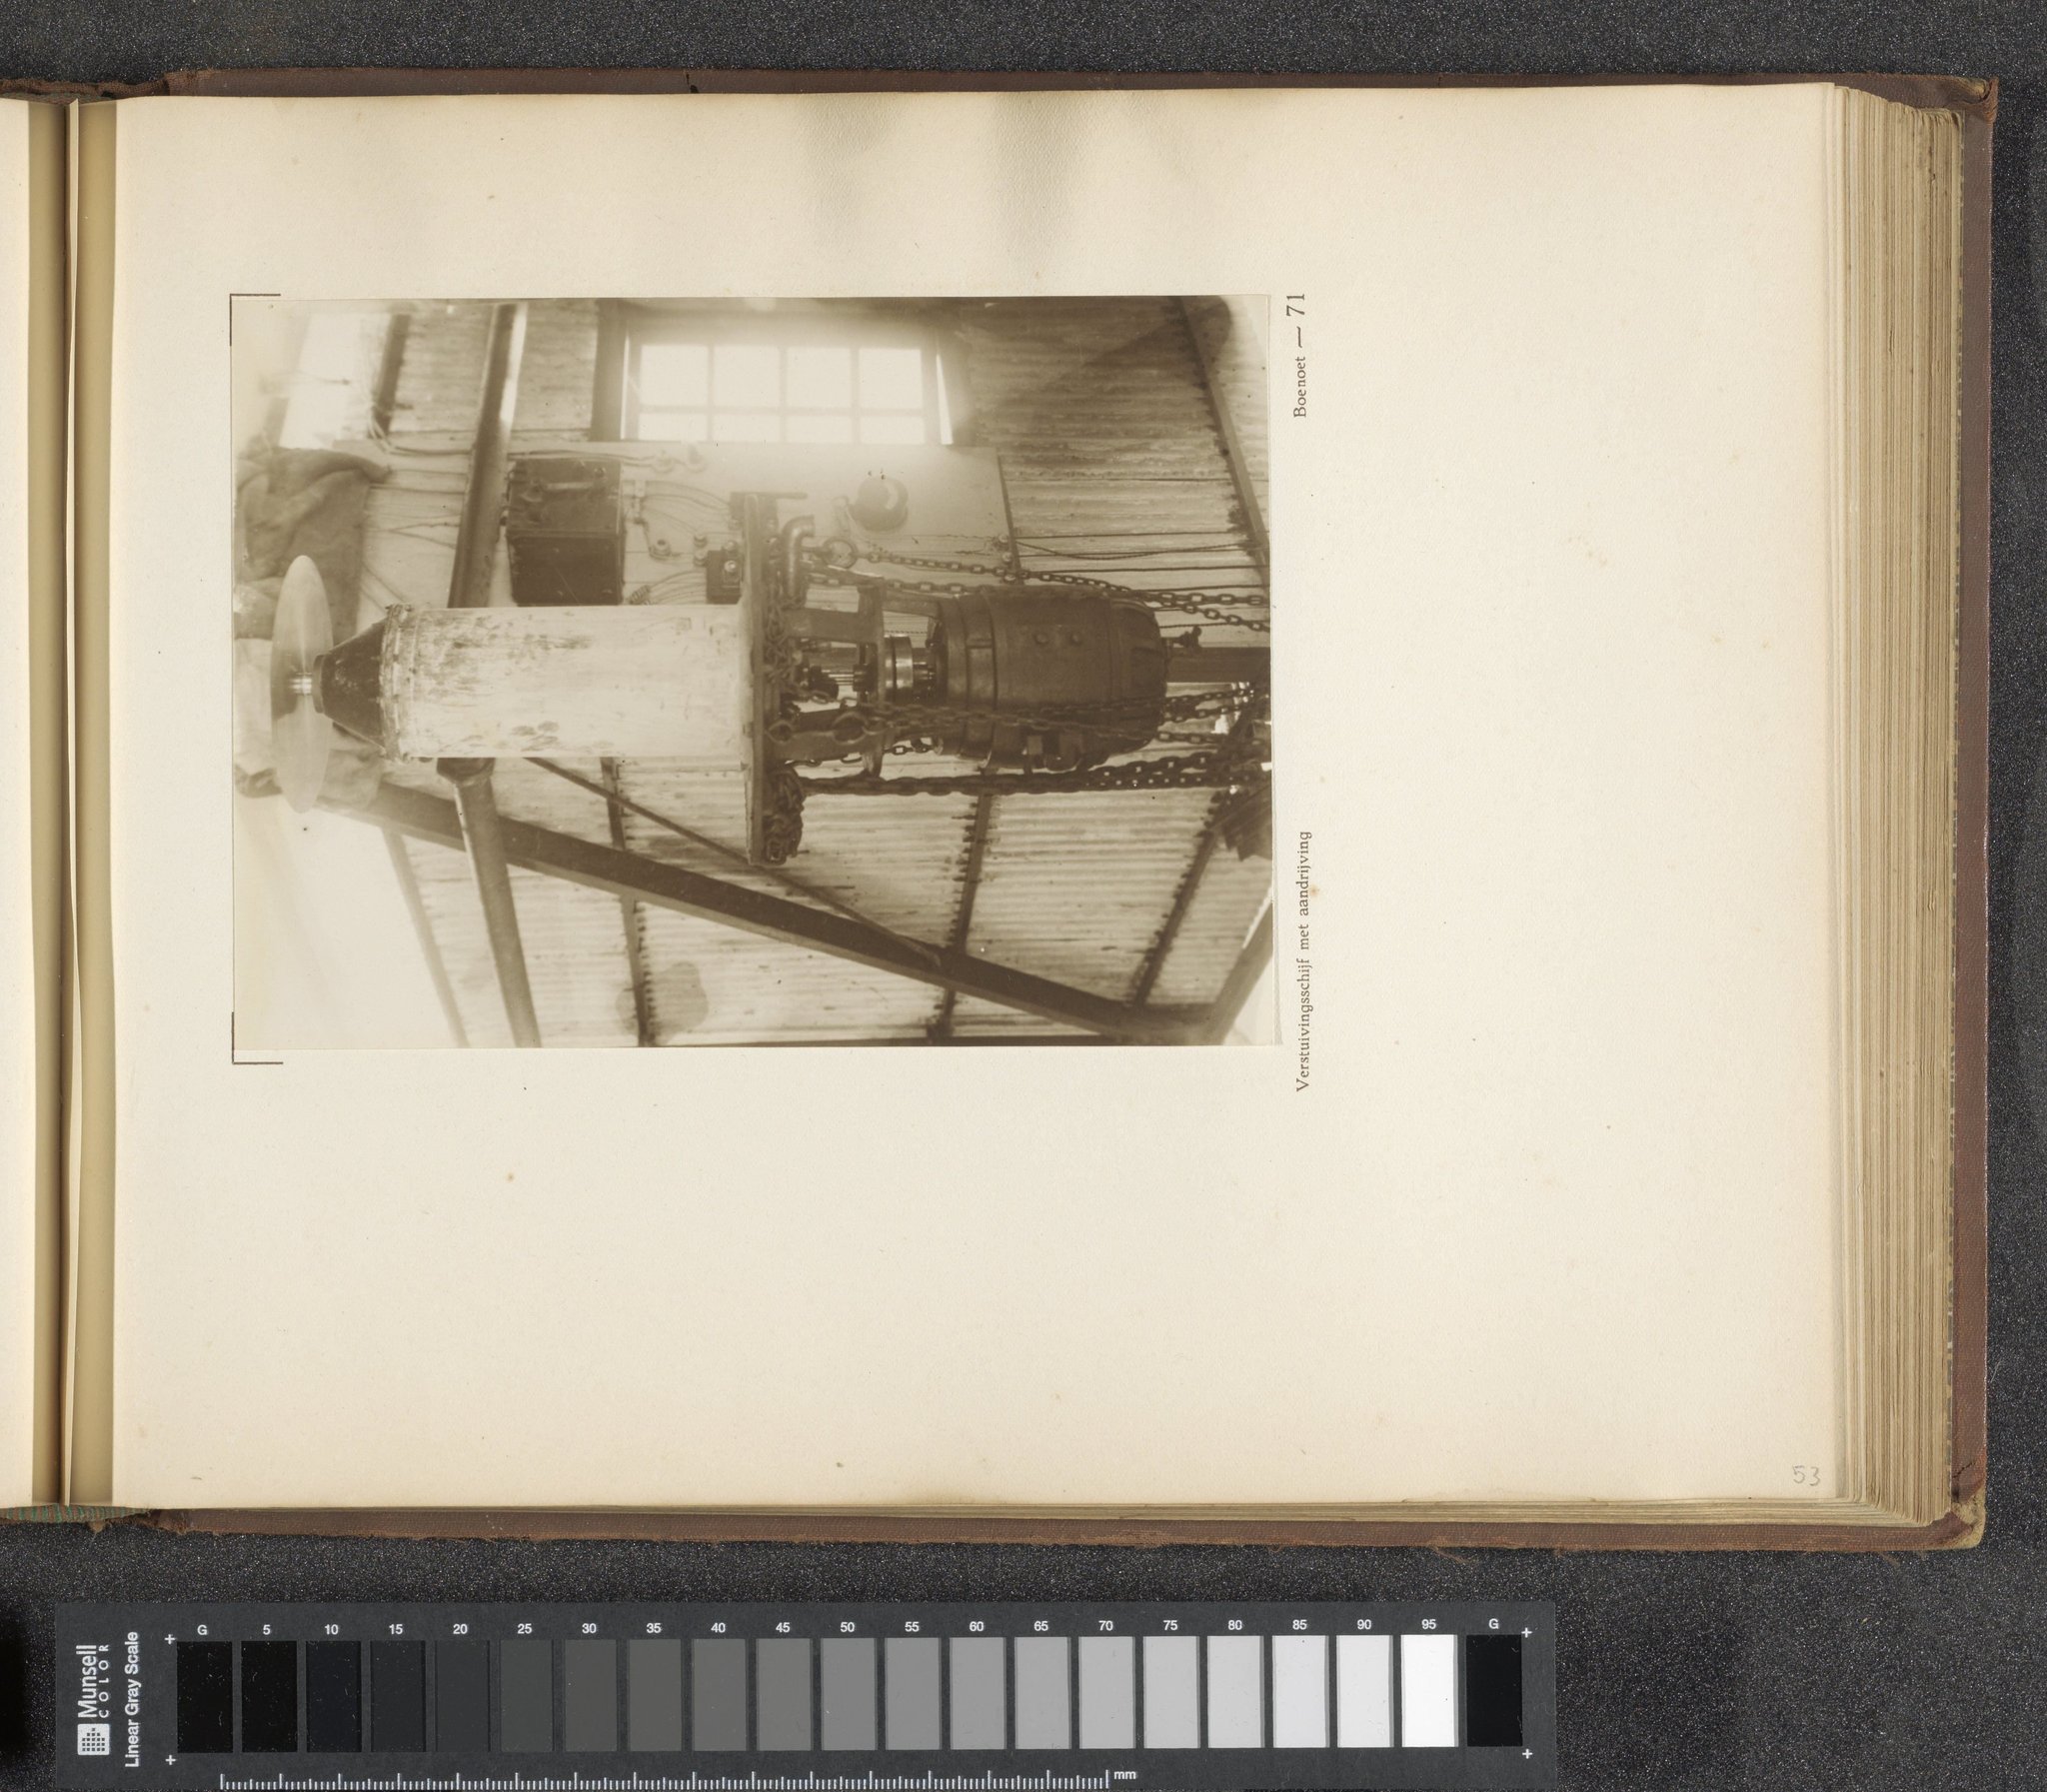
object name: photograph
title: Pagina 71 van fotoboek van de Algemeene Vereeniging van Rubberplanters ter Oostkust van Sumatra (A.V.R.O.S.)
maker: j.w. meyster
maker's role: fotograaf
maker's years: 1887-1945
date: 1924-1925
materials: paper, photographic support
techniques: printing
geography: dutch east indies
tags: factory-building, factory-interior, machine shop, (non-fruit) products of plants or trees: rubber, sumatra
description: Boekpagina met een foto van een verstuivingsschijf met aandrijving in een rubberfabriek van de Algemeene Vereeniging van Rubberplanters ter Oostkust van Sumatra (A.V.R.O.S.) te Boenoet. Onderdeel van een fotoboek van de Algemeene Vereeniging van Rubberplanters ter Oostkust van Sumatra (A.V.R.O.S.).